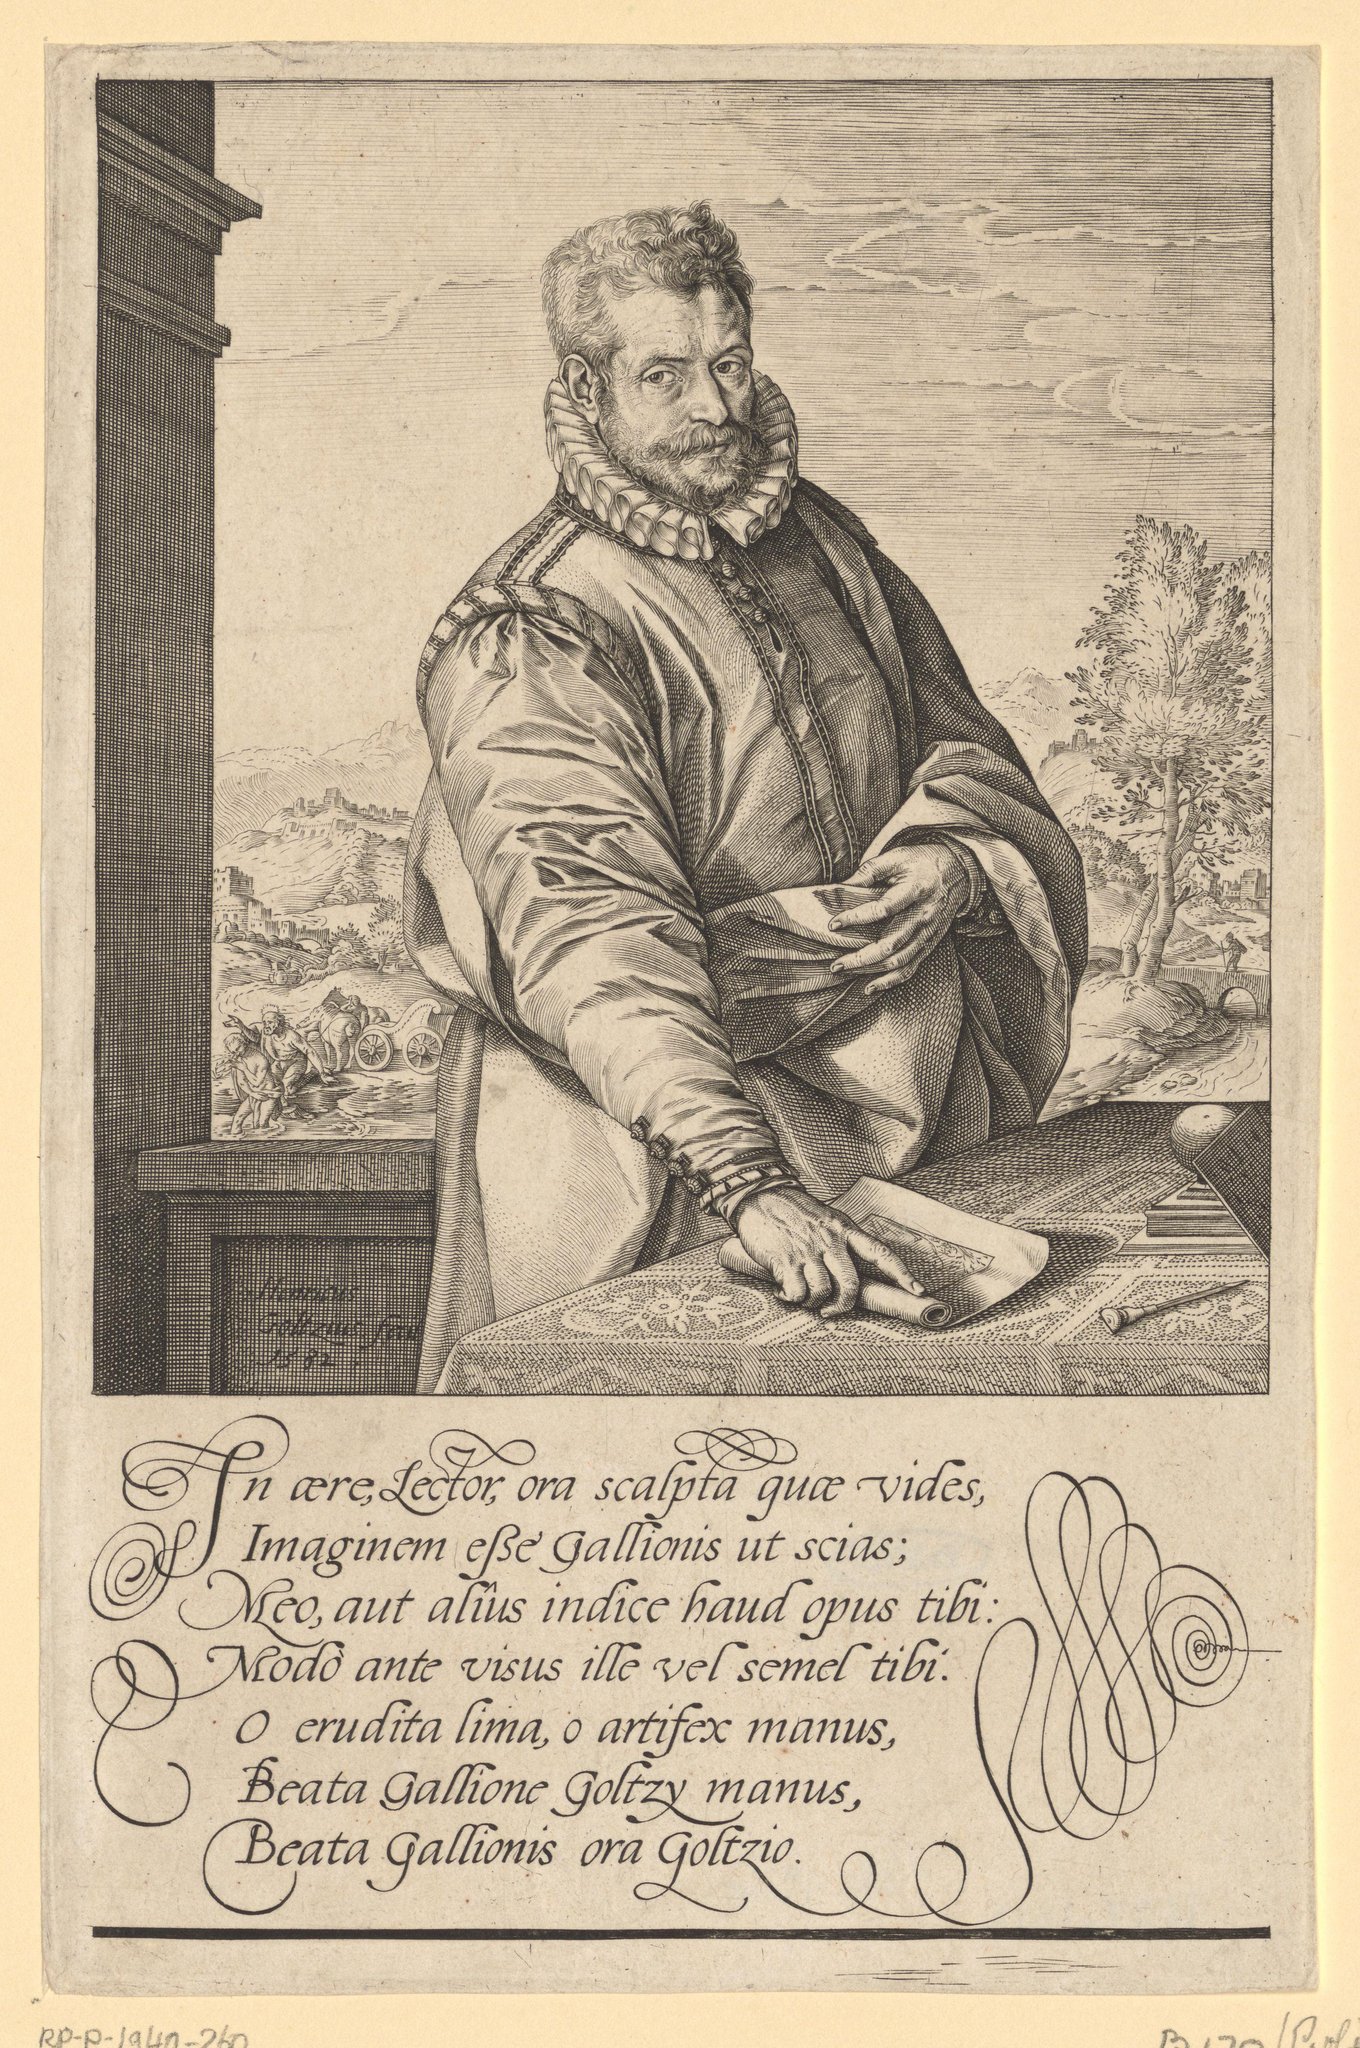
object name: print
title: Portret van Philips Galle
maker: hendrick goltzius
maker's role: draughtsman, painter, print maker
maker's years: 1558-1617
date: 1582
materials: paper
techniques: engraving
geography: haarlem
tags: haarlem, antwerp, print maker, publisher, philips galle, historical persons, portrait, self-portrait of artist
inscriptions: collector's mark: Lugt 2228